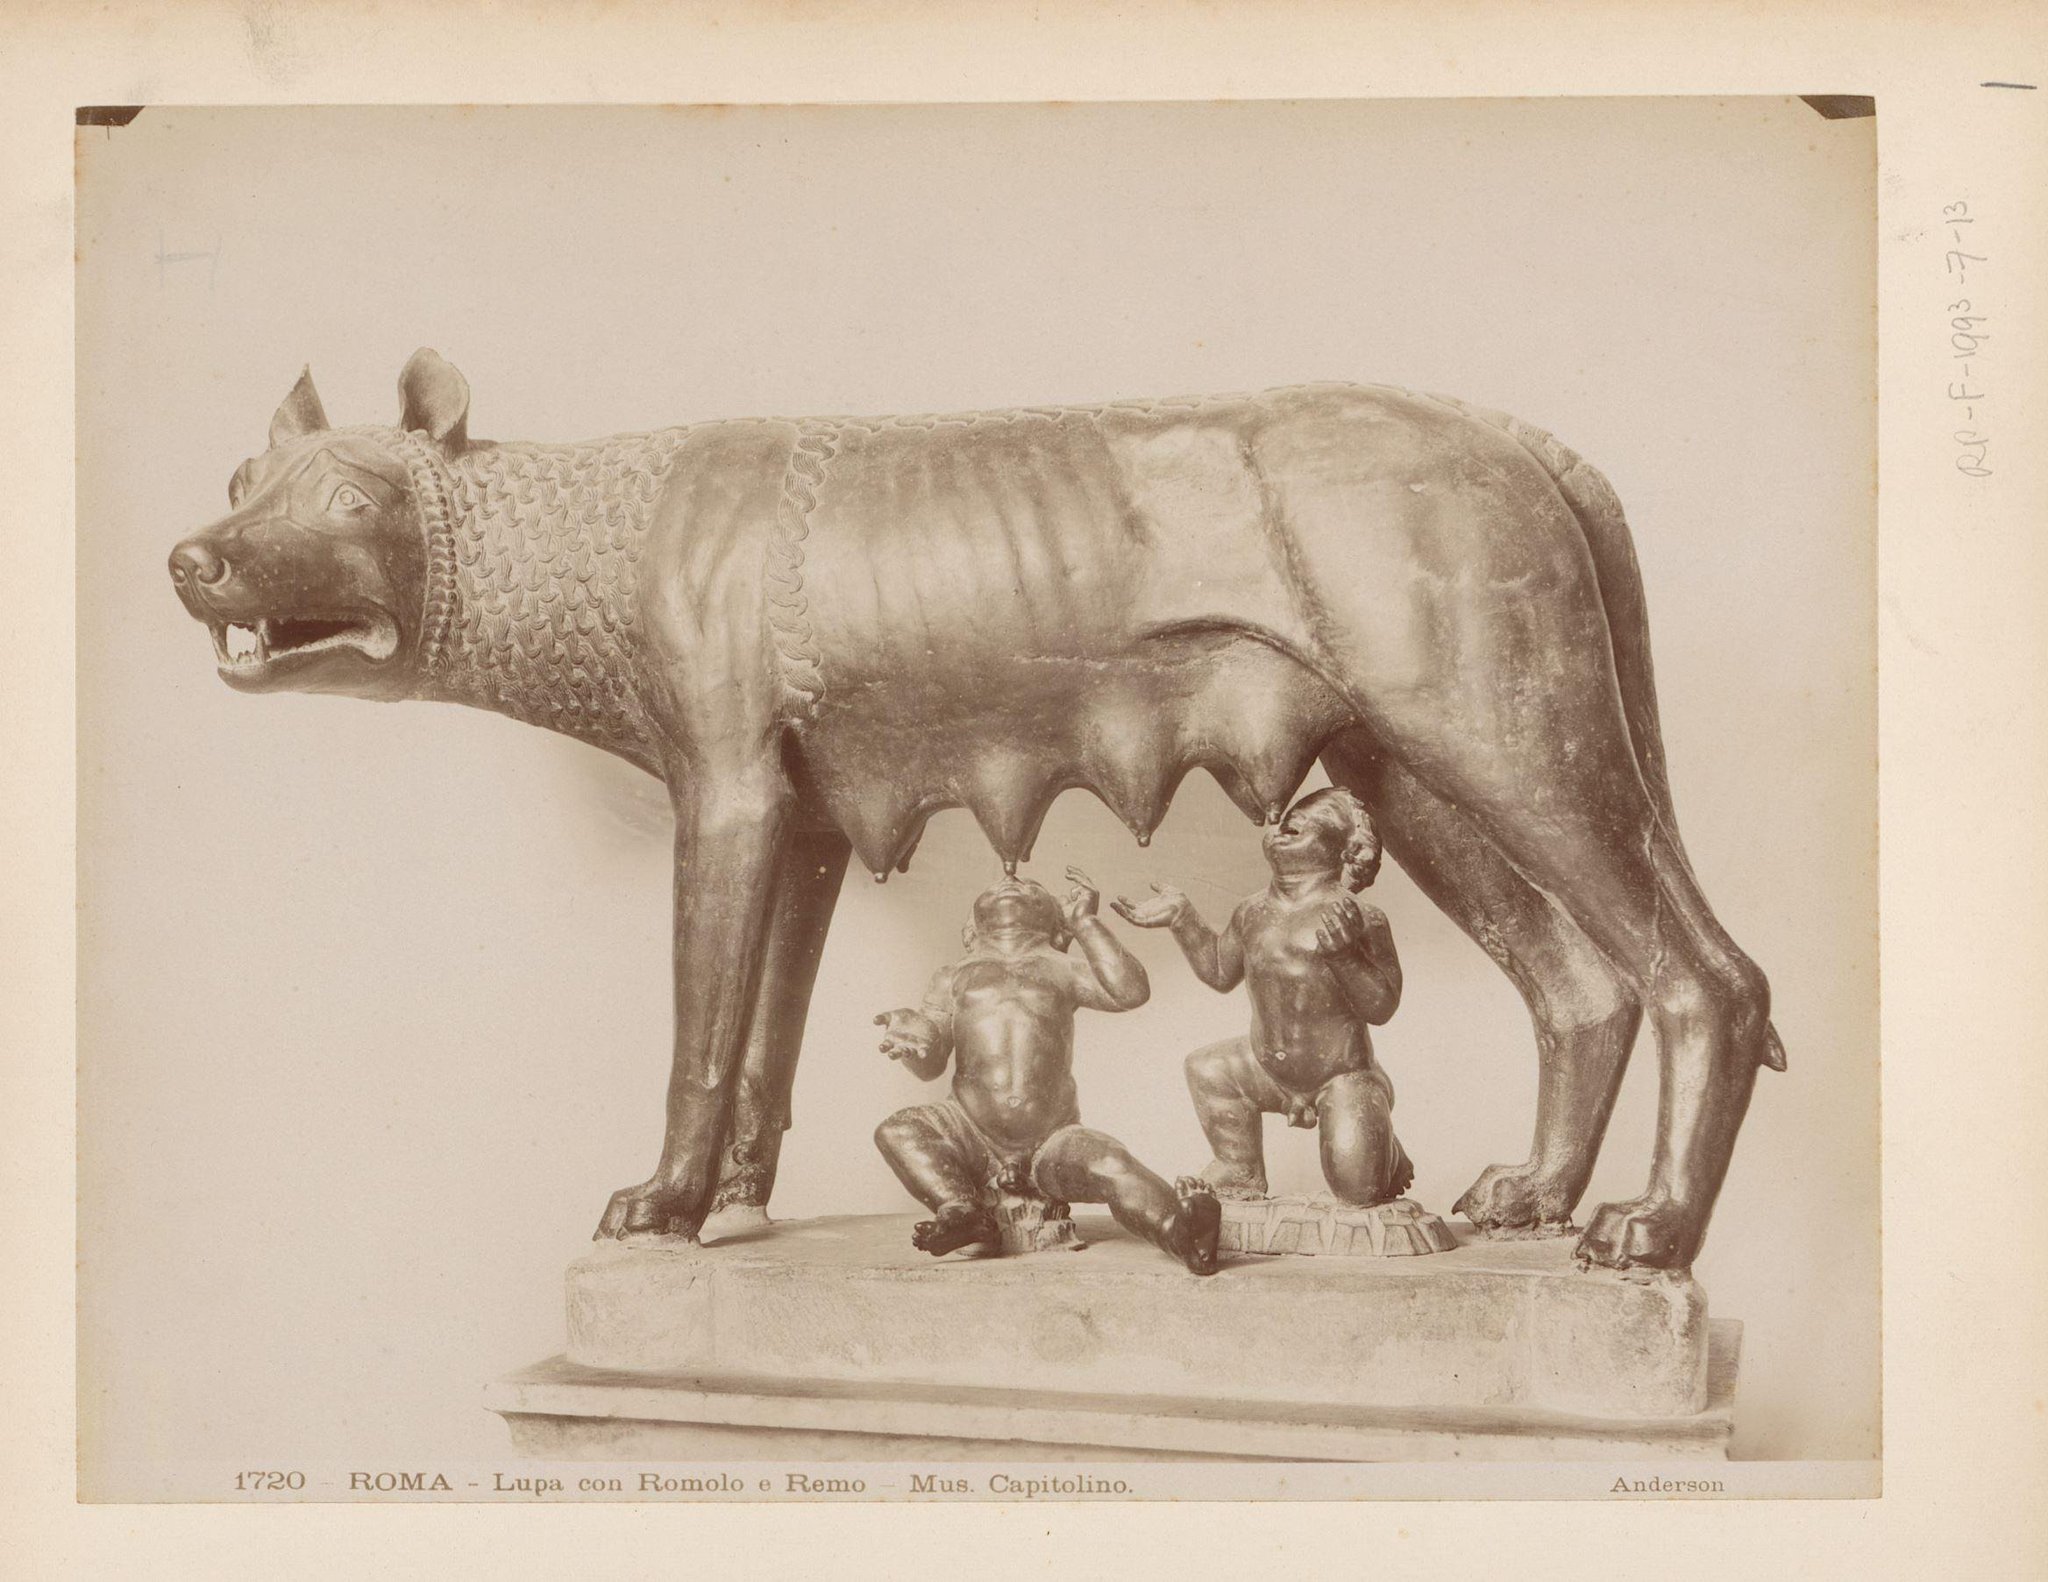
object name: photograph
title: 1720 - Roma - Lupa con Romolo e Remo - Mus. Capitolino.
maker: james anderson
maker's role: fotograaf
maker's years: 1813-1877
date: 1857-1875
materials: paper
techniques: albumen print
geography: capitolijnse musea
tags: romulus and remus are washed ashore and suckled by a she-wolf; 'lupa romana', piece of sculpture, reproduction of a piece of sculpture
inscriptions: inscription: ‘1720 - ROMA - Lupa con Romolo e Remo Mus. Capitolino. Anderson’